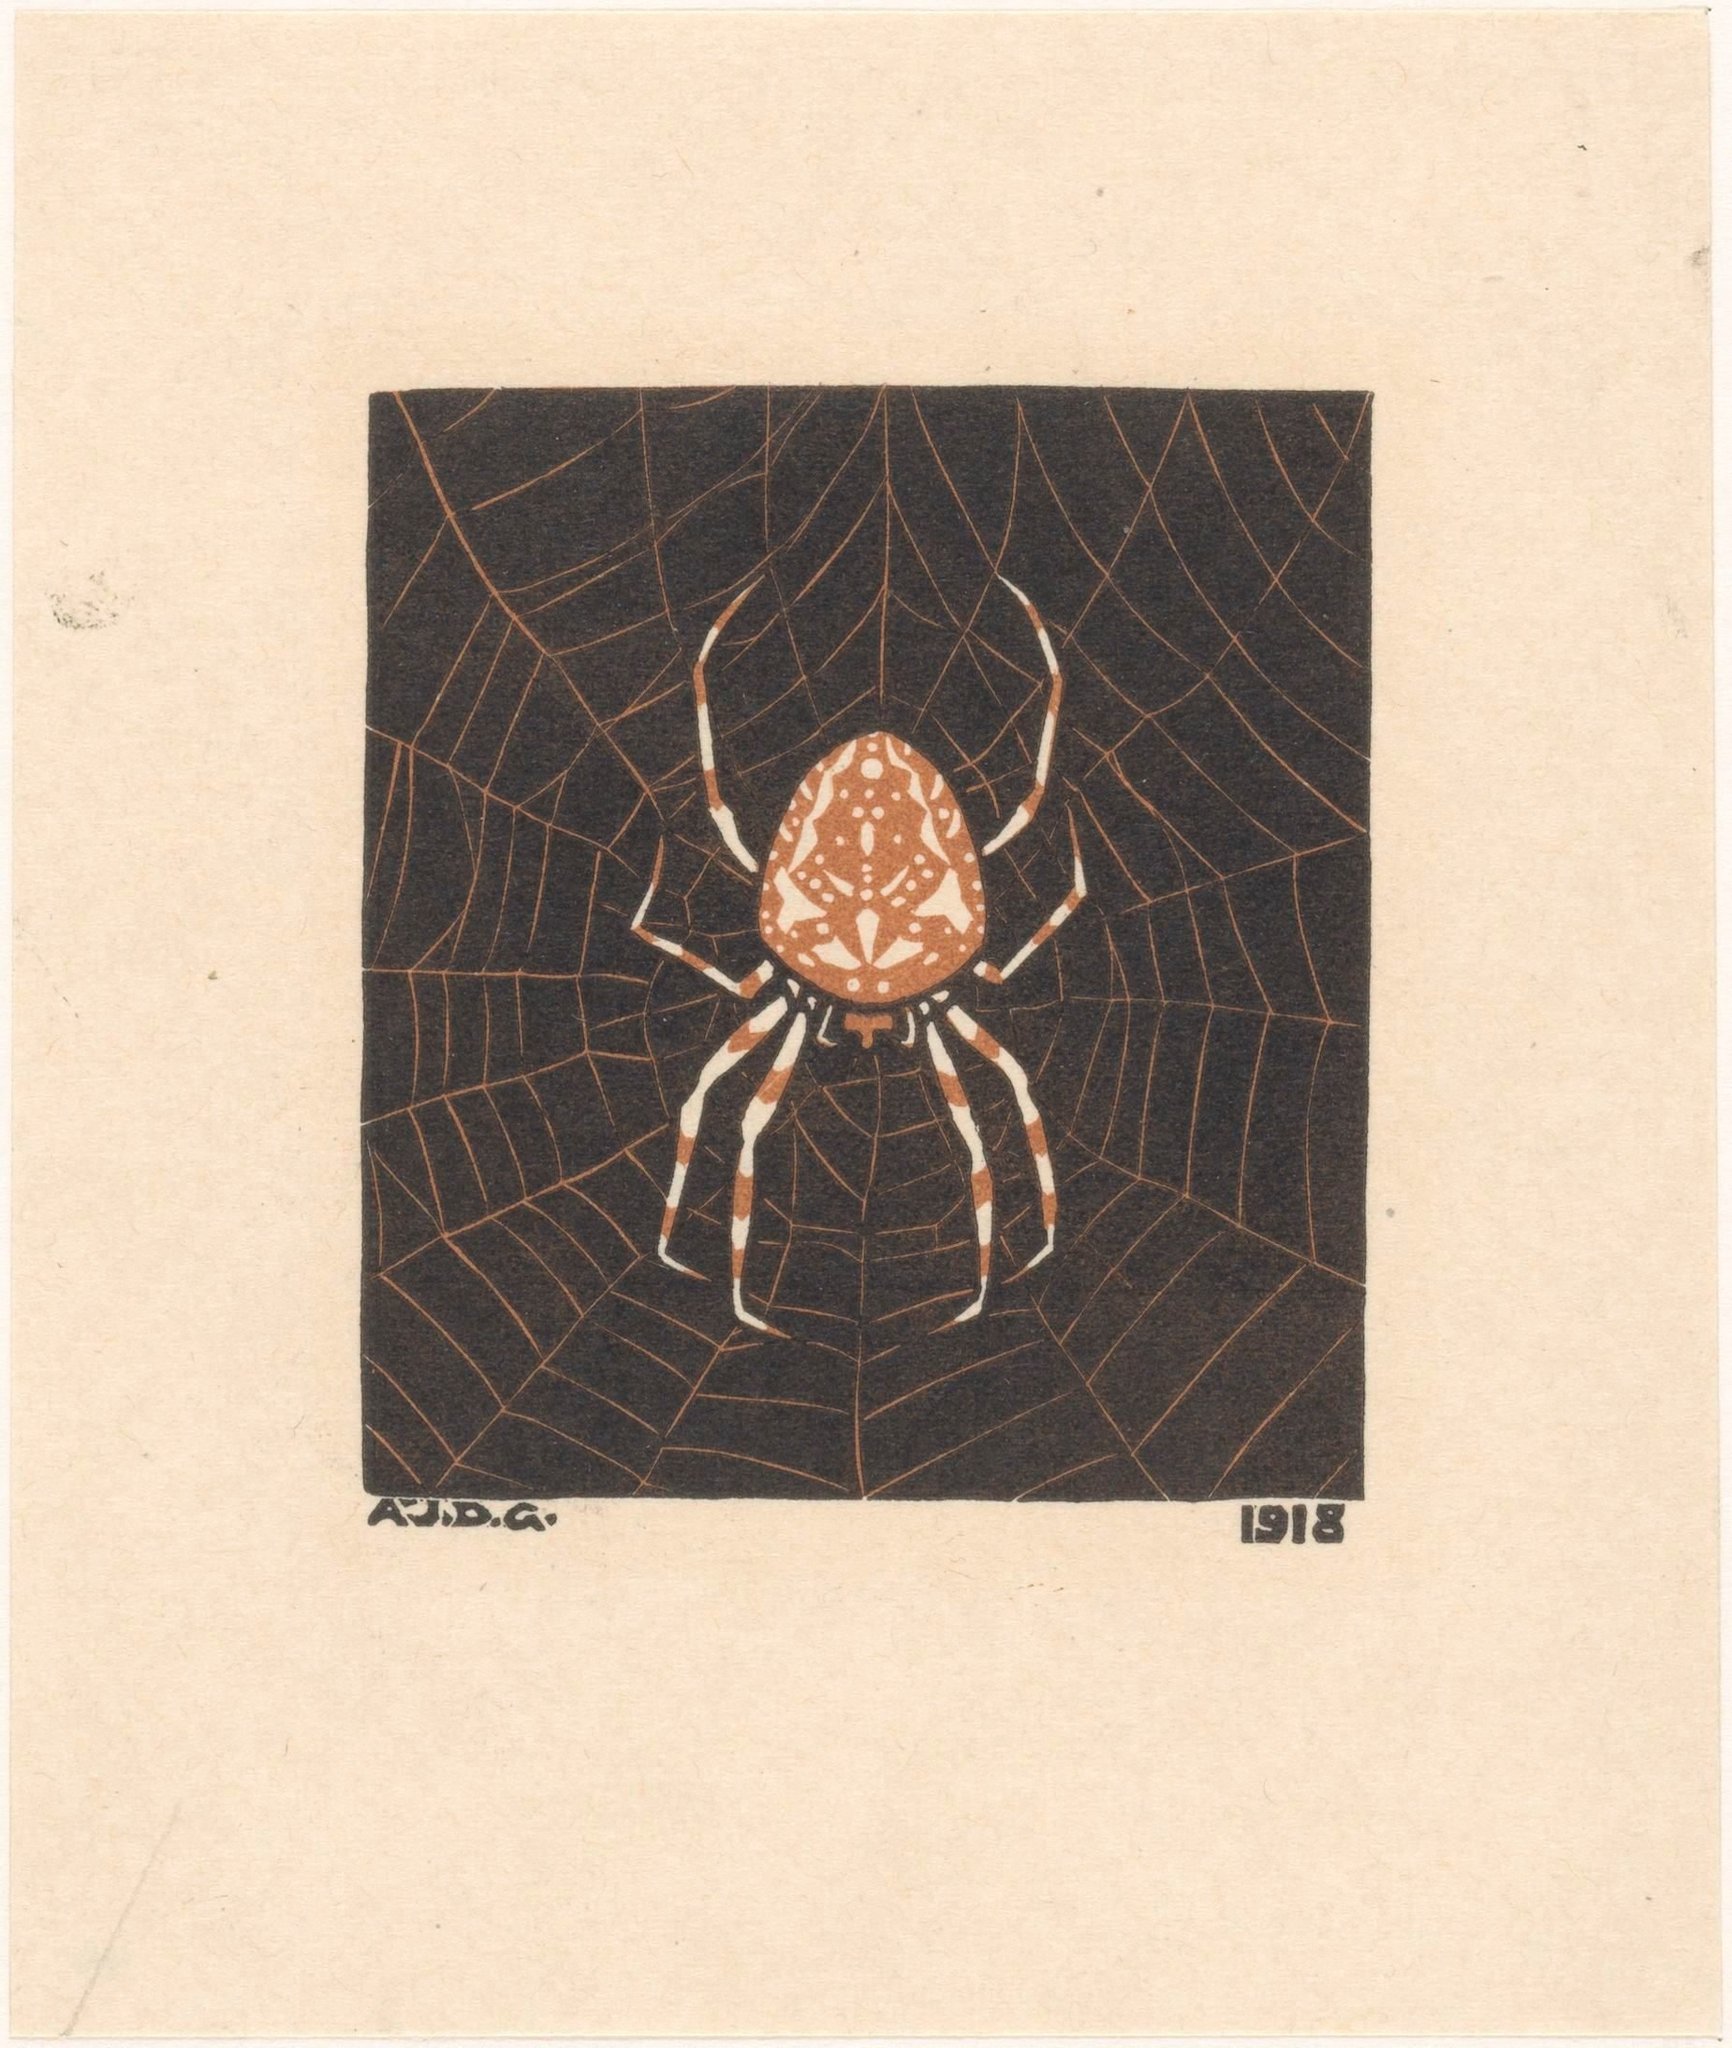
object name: print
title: Spin in een web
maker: julie de graag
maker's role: draughtsman, print maker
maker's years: 1877-1924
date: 1918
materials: paper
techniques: woodcut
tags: spiders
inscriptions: collector's mark: Lugt 2228